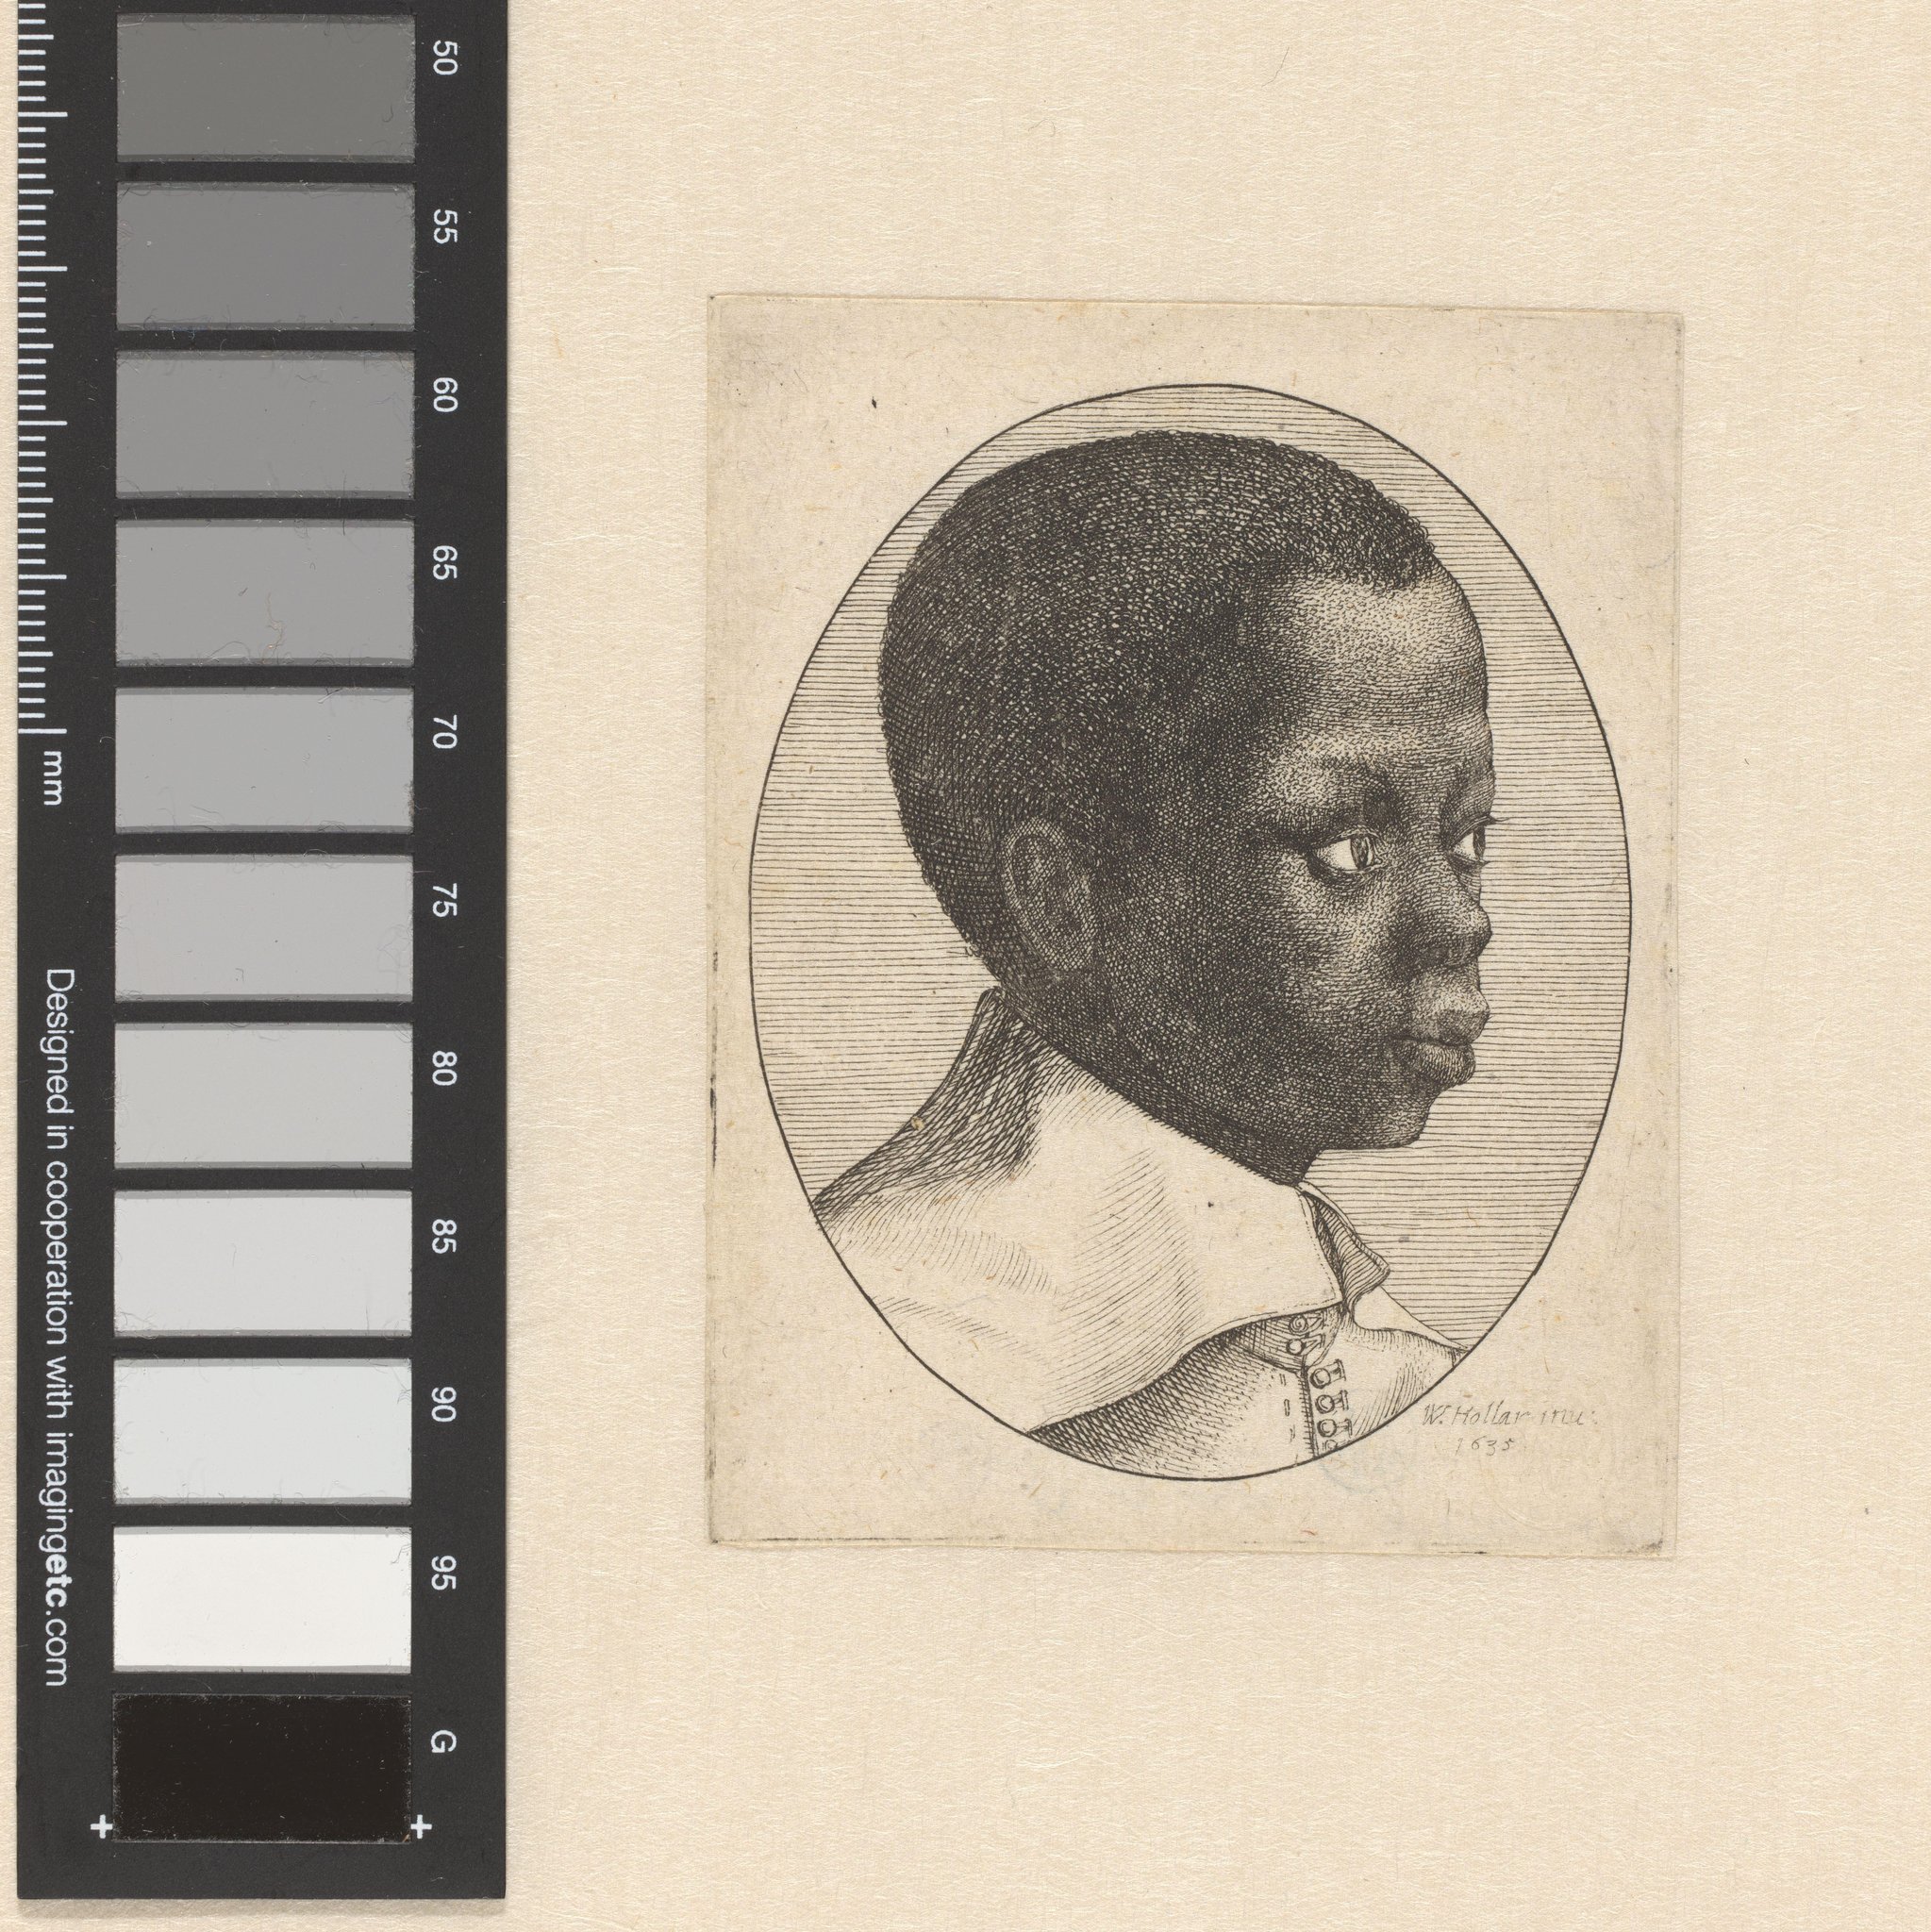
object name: print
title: Portret van een jongen van Afrikaanse herkomst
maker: wenceslaus hollar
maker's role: draughtsman, print maker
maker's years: 1607-1677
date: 1635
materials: ink, paper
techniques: etching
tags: anonymous historical person portrayed alone, africans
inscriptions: collector's mark: Lugt 1966, collector's mark: Lugt 2228, collector's mark: Lugt 533b, collector's mark: Lugt 2760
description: De ets gaat hoogstwaarschijnlijk terug op een tekening die Hollar maakte tijdens zijn verblijf in Holland en Amsterdam in 1633-34.